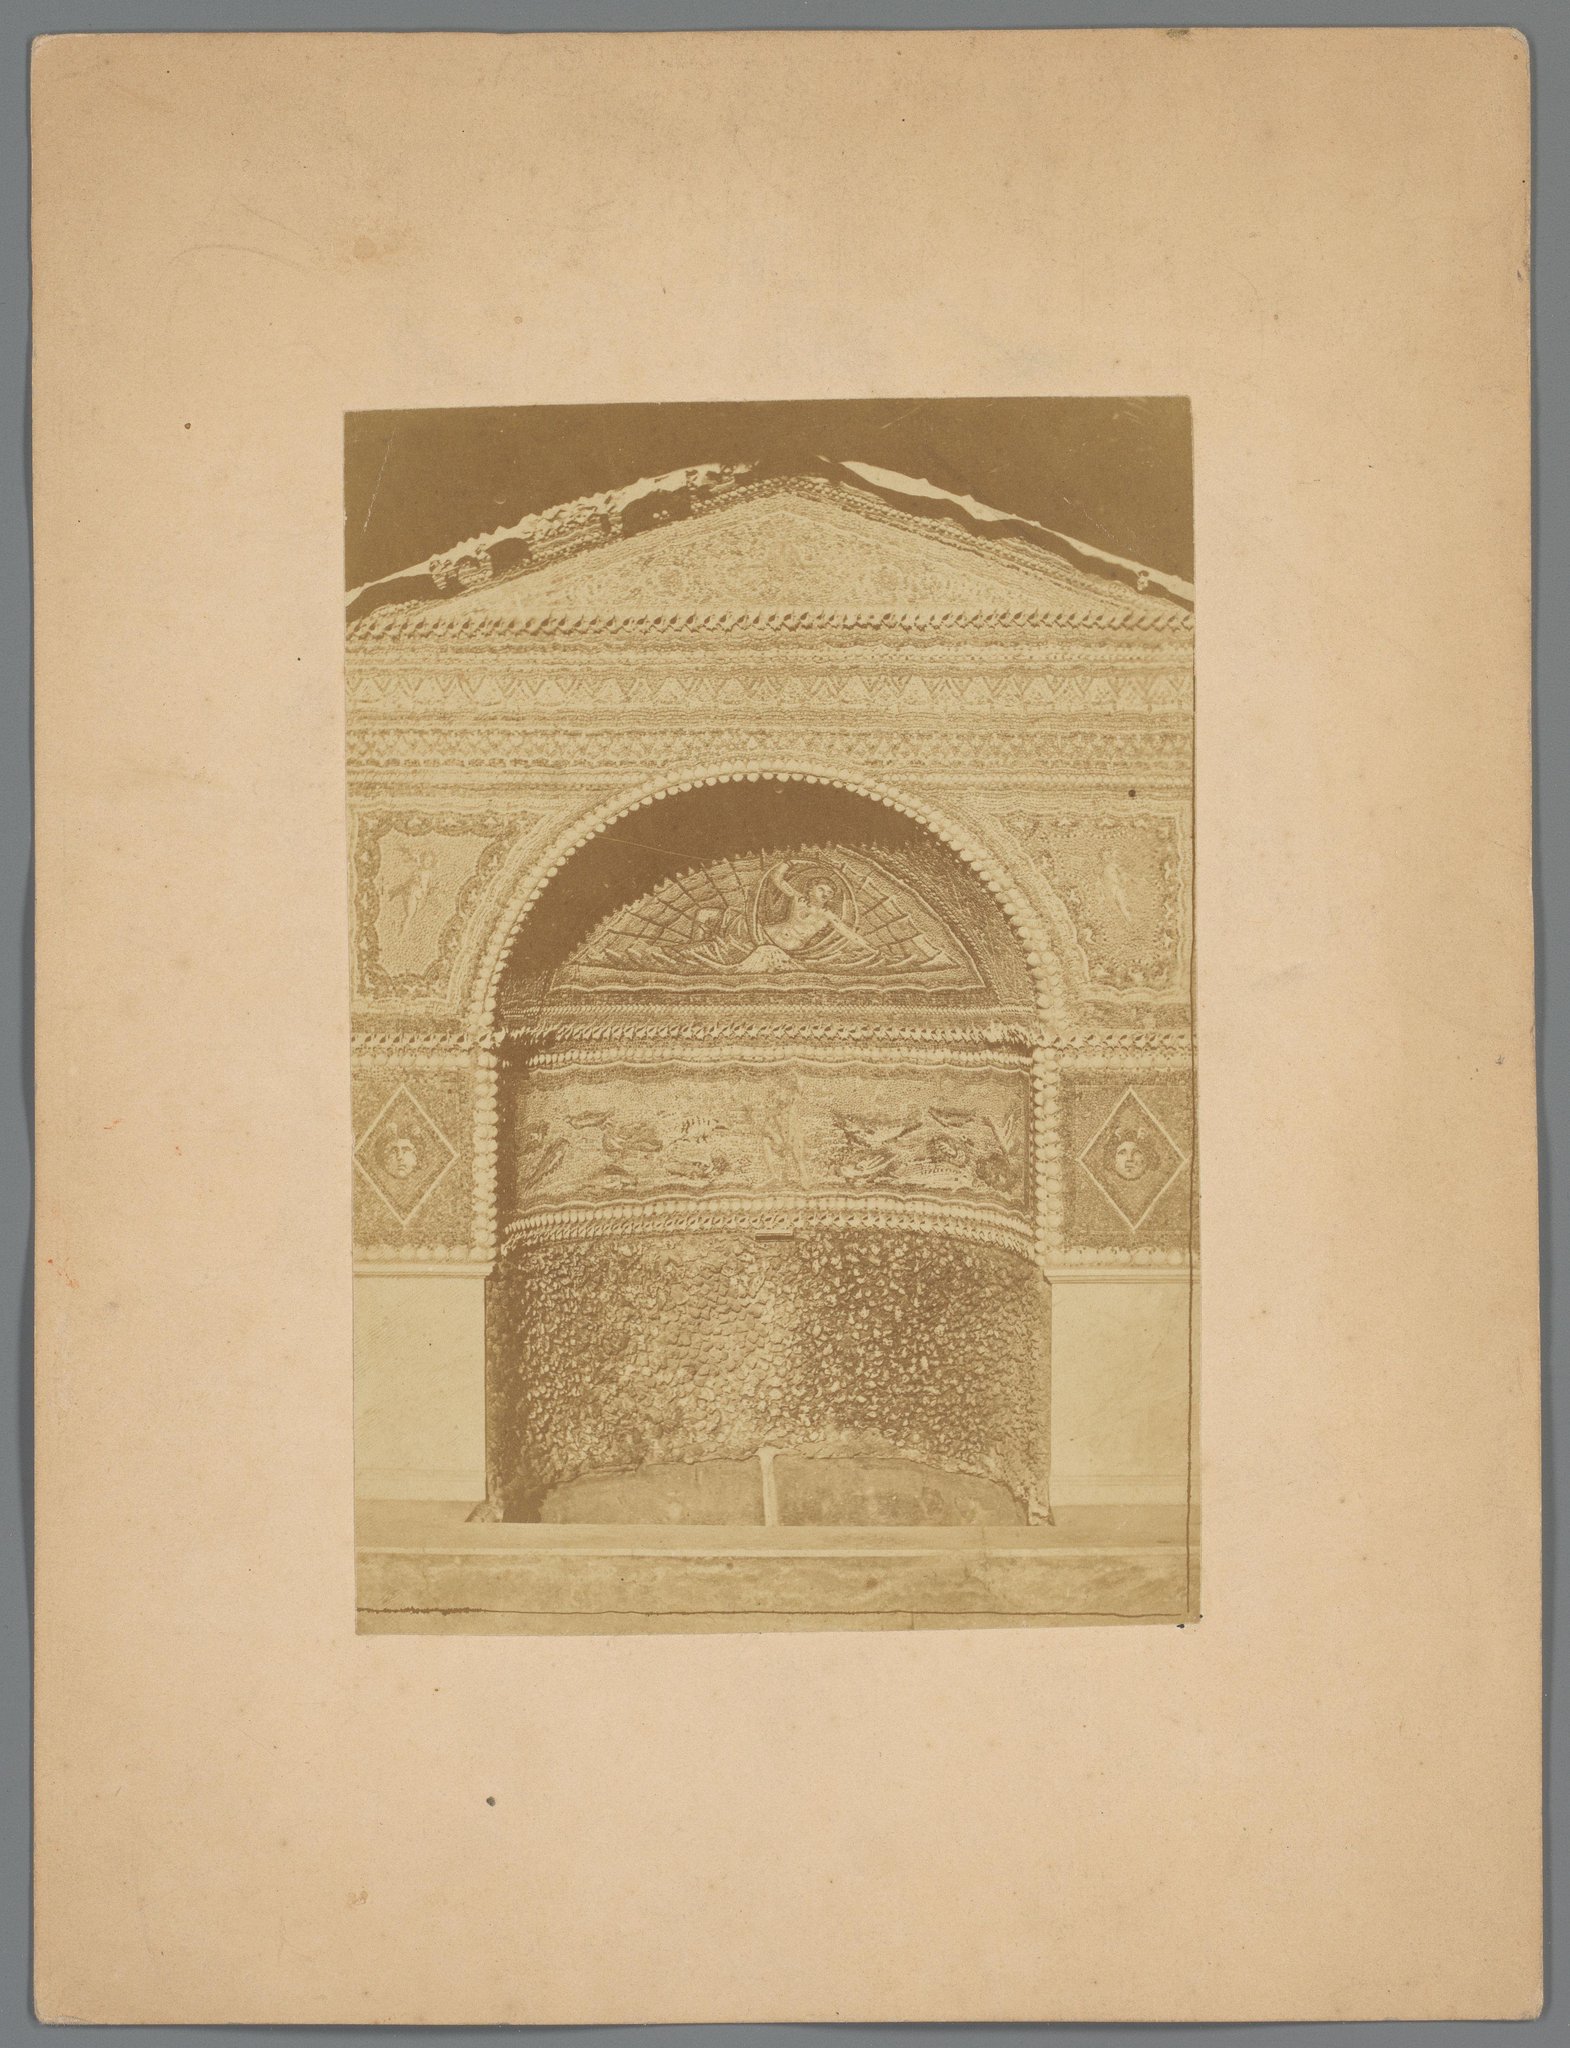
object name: photograph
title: Nis met mozaïeken en fontein in Pompeï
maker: Anonymous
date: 1868-1890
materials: paper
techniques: albumen print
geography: pompeii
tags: ornamental fountain, pompeii